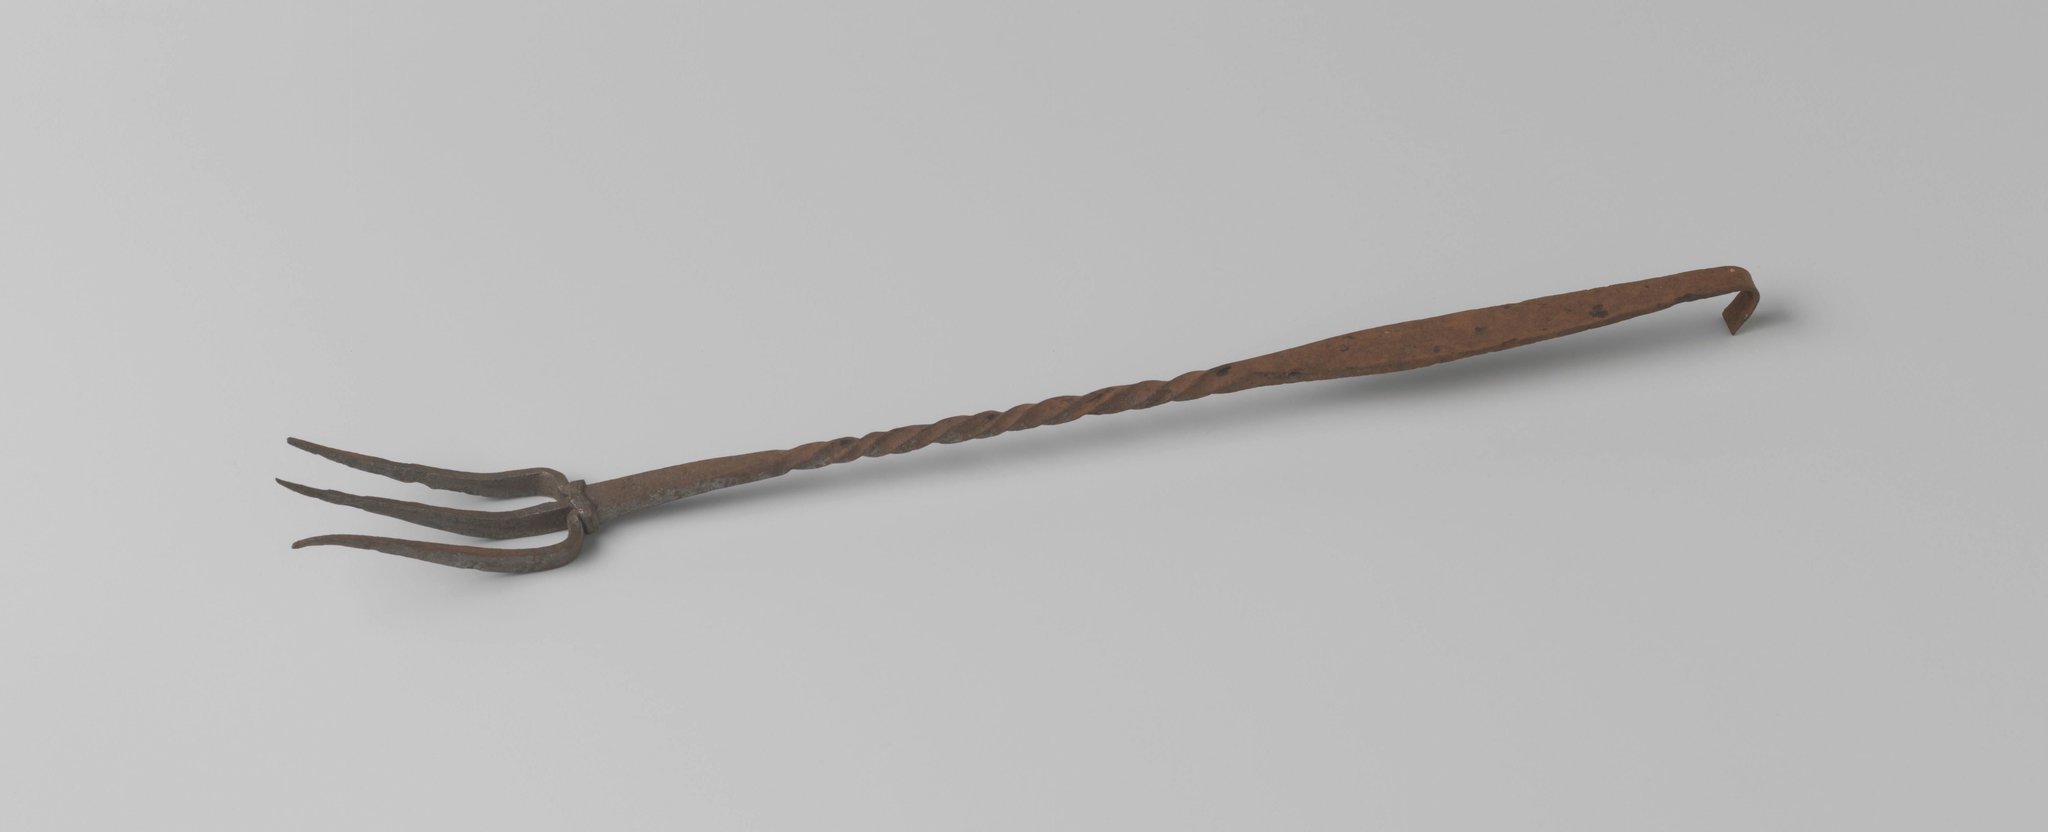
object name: fork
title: Vork met gedraaide steel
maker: Anonymous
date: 1400-1950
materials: iron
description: Een ijzeren braadvork met met drie tanden en een gedraaide steel.